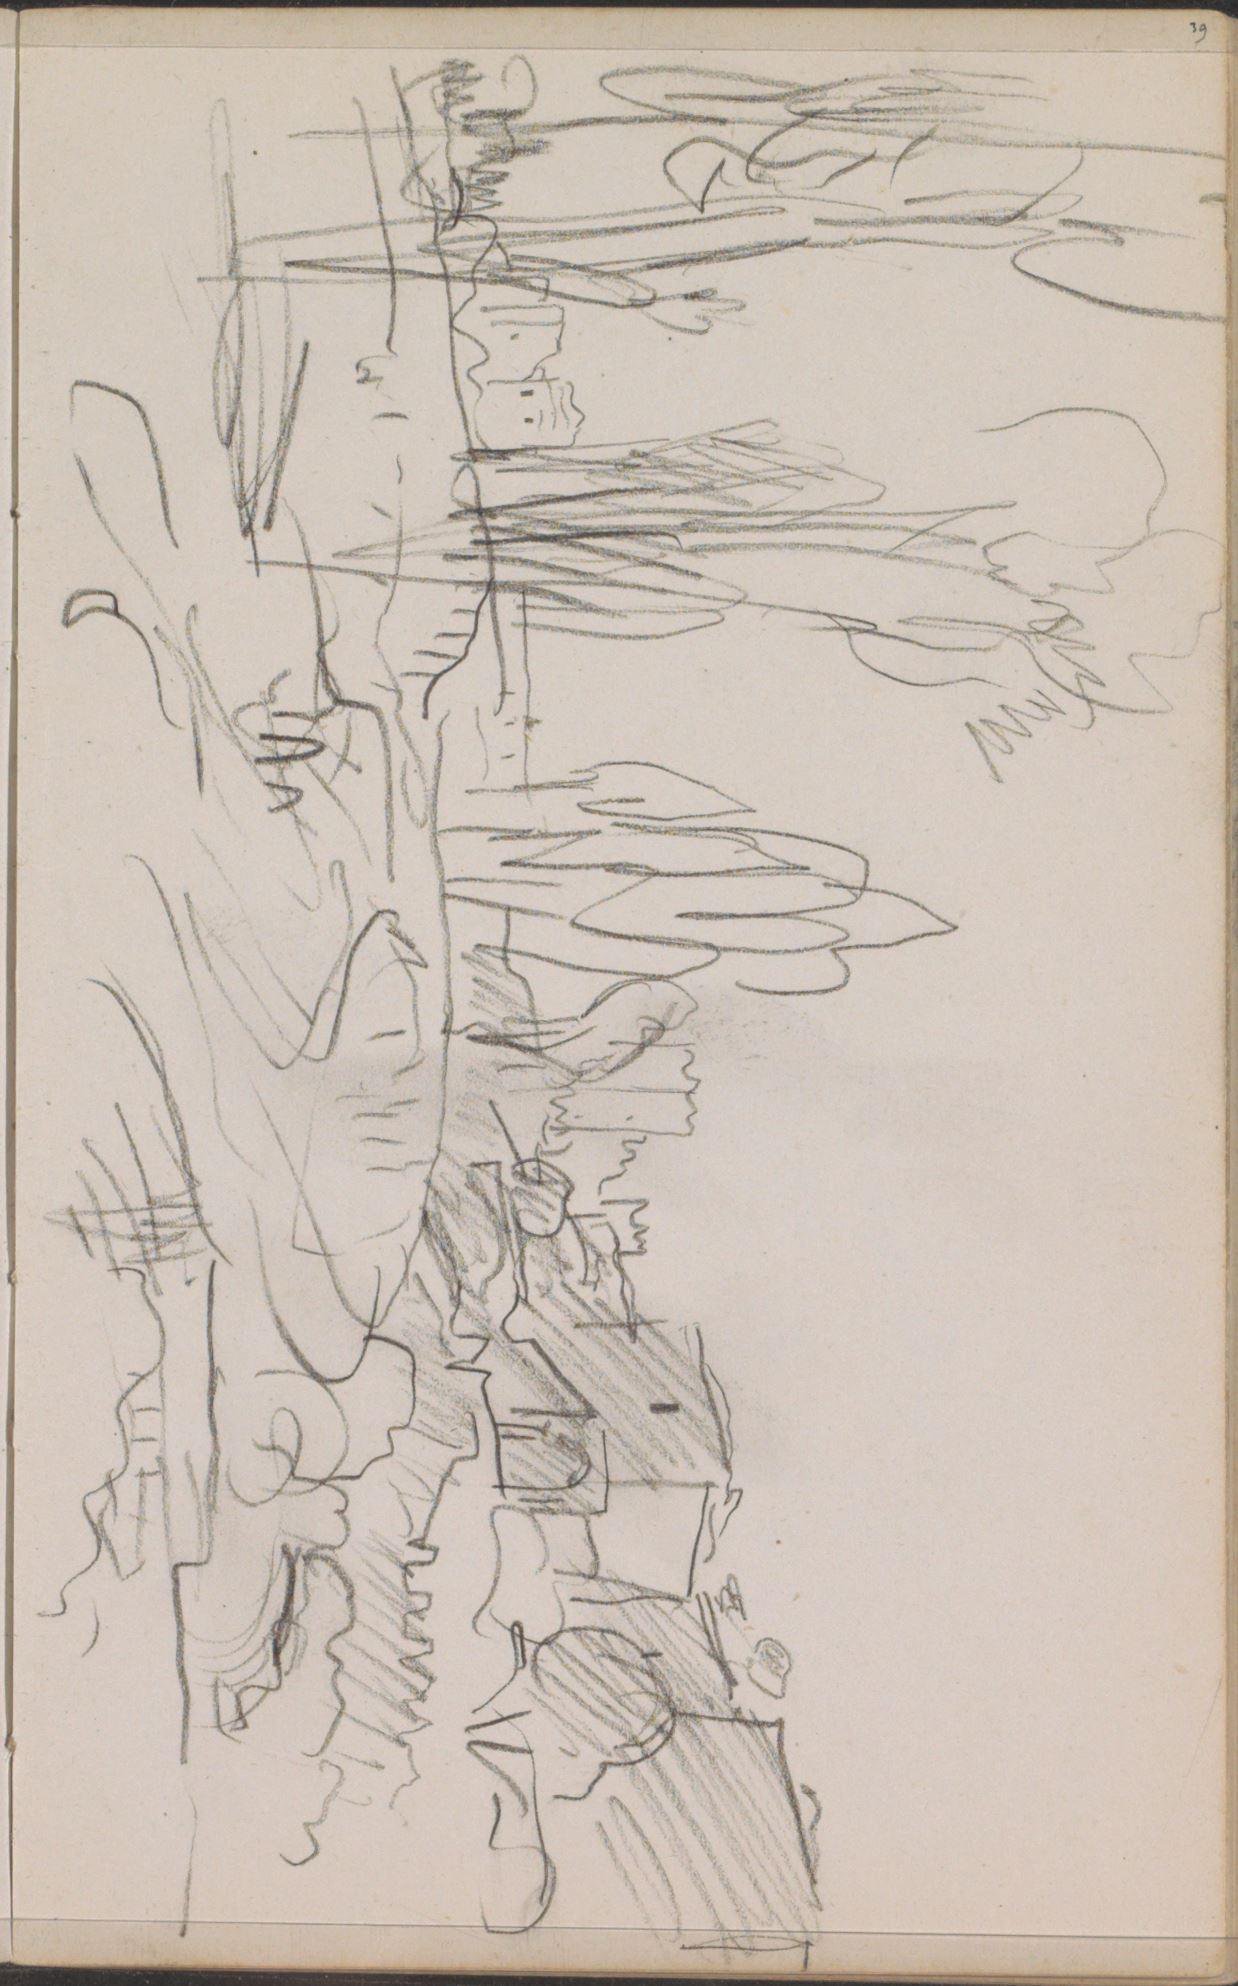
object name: sketchbook leaf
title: Landschap met bomen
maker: marius bauer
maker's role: draughtsman, print maker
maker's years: 1867-1932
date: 1896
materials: chalk, paper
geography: turkey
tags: city-view, and landscape with man-made constructions, trees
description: Pagina 39 uit een schetsboek met 53 bladen.